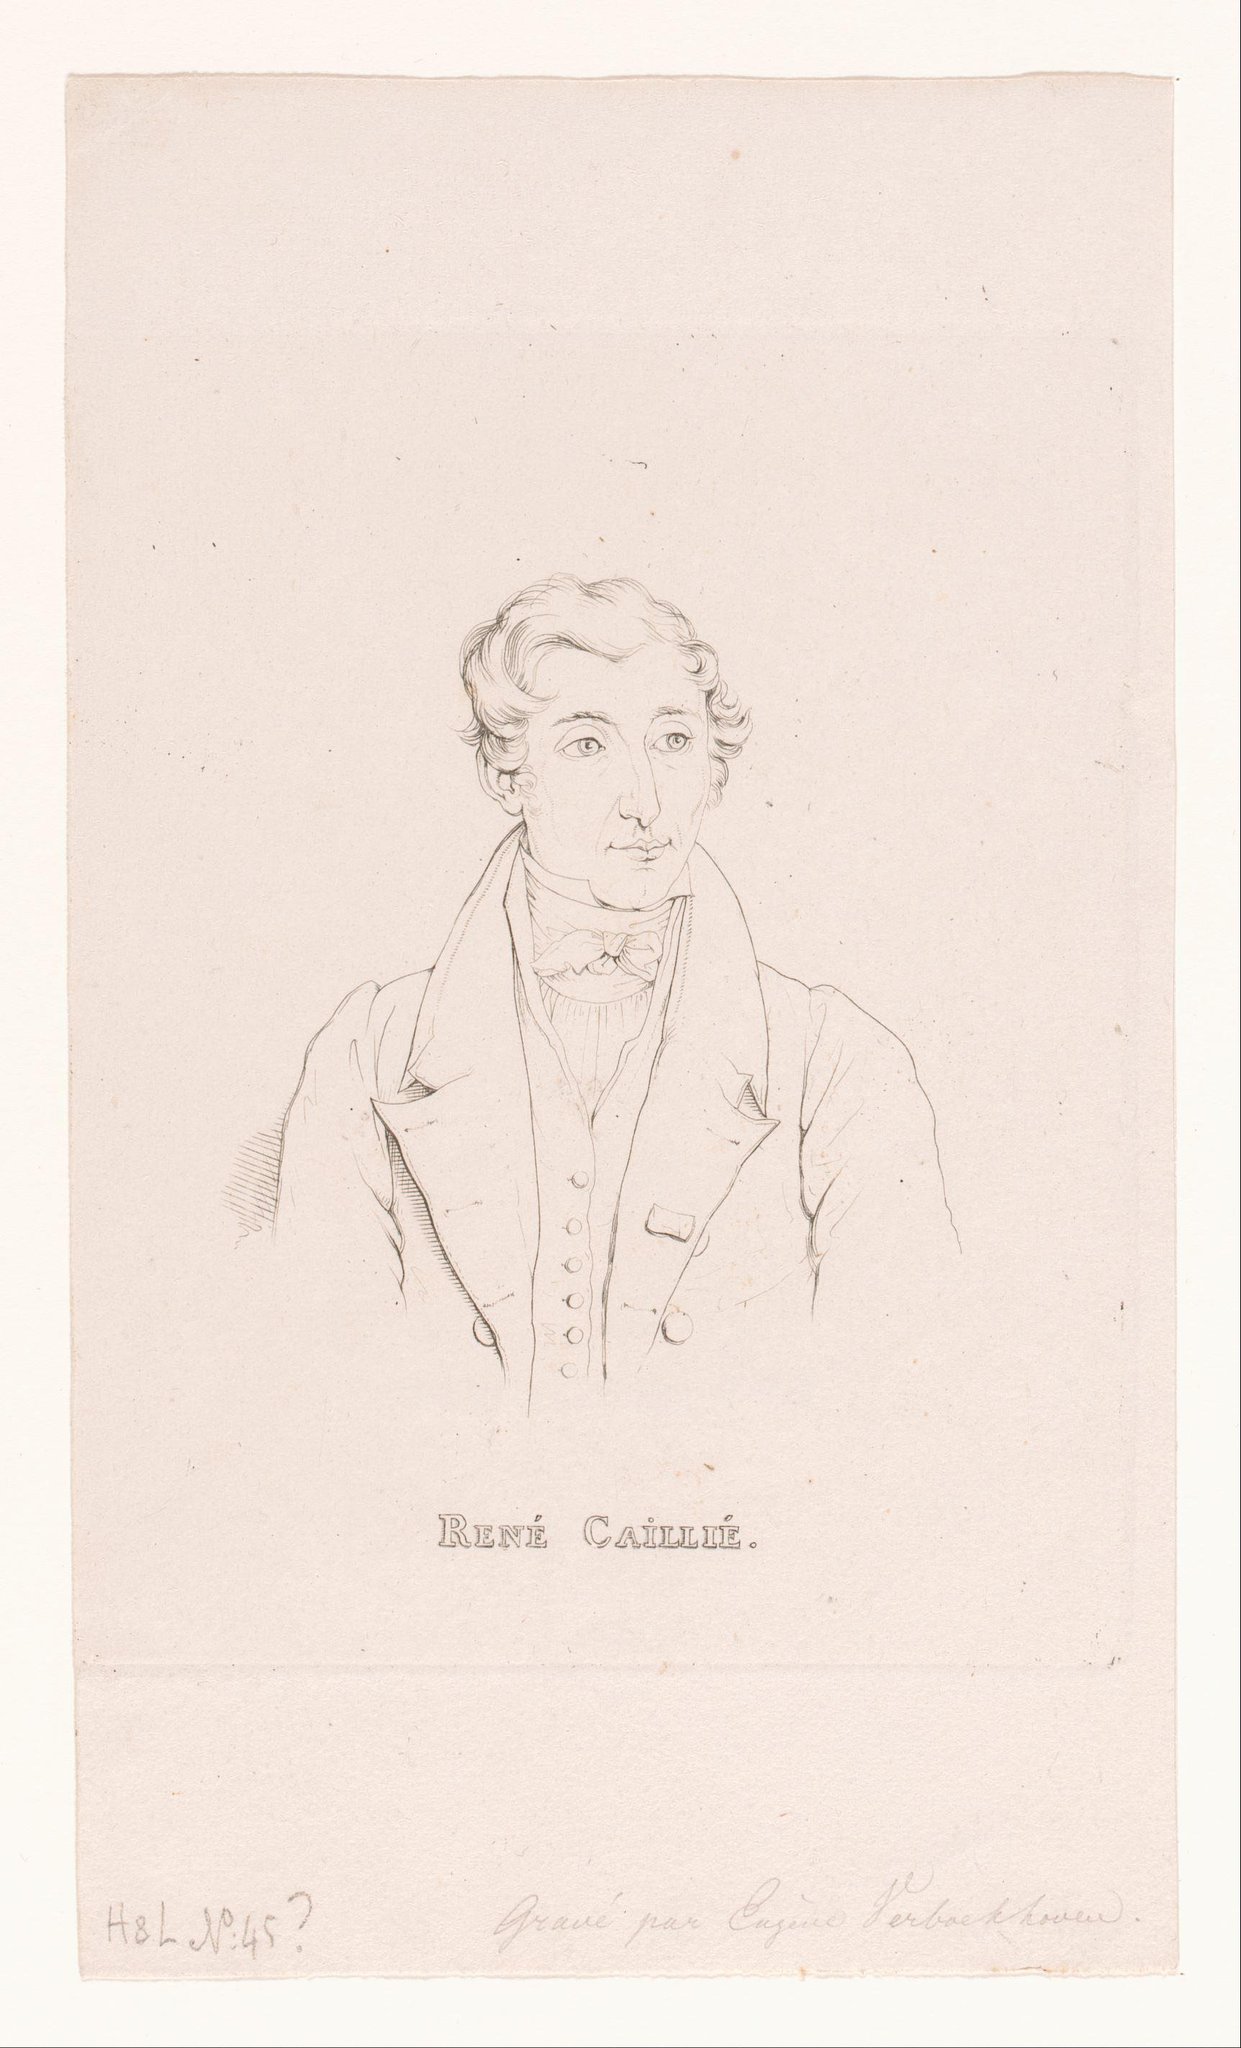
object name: print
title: René Caillié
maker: eugène verboeckhoven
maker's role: draughtsman, painter, print maker, printer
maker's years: 1798-1881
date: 1808-1881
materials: paper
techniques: engraving, etching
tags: historical persons, explorer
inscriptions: collector's mark: Lugt 2228